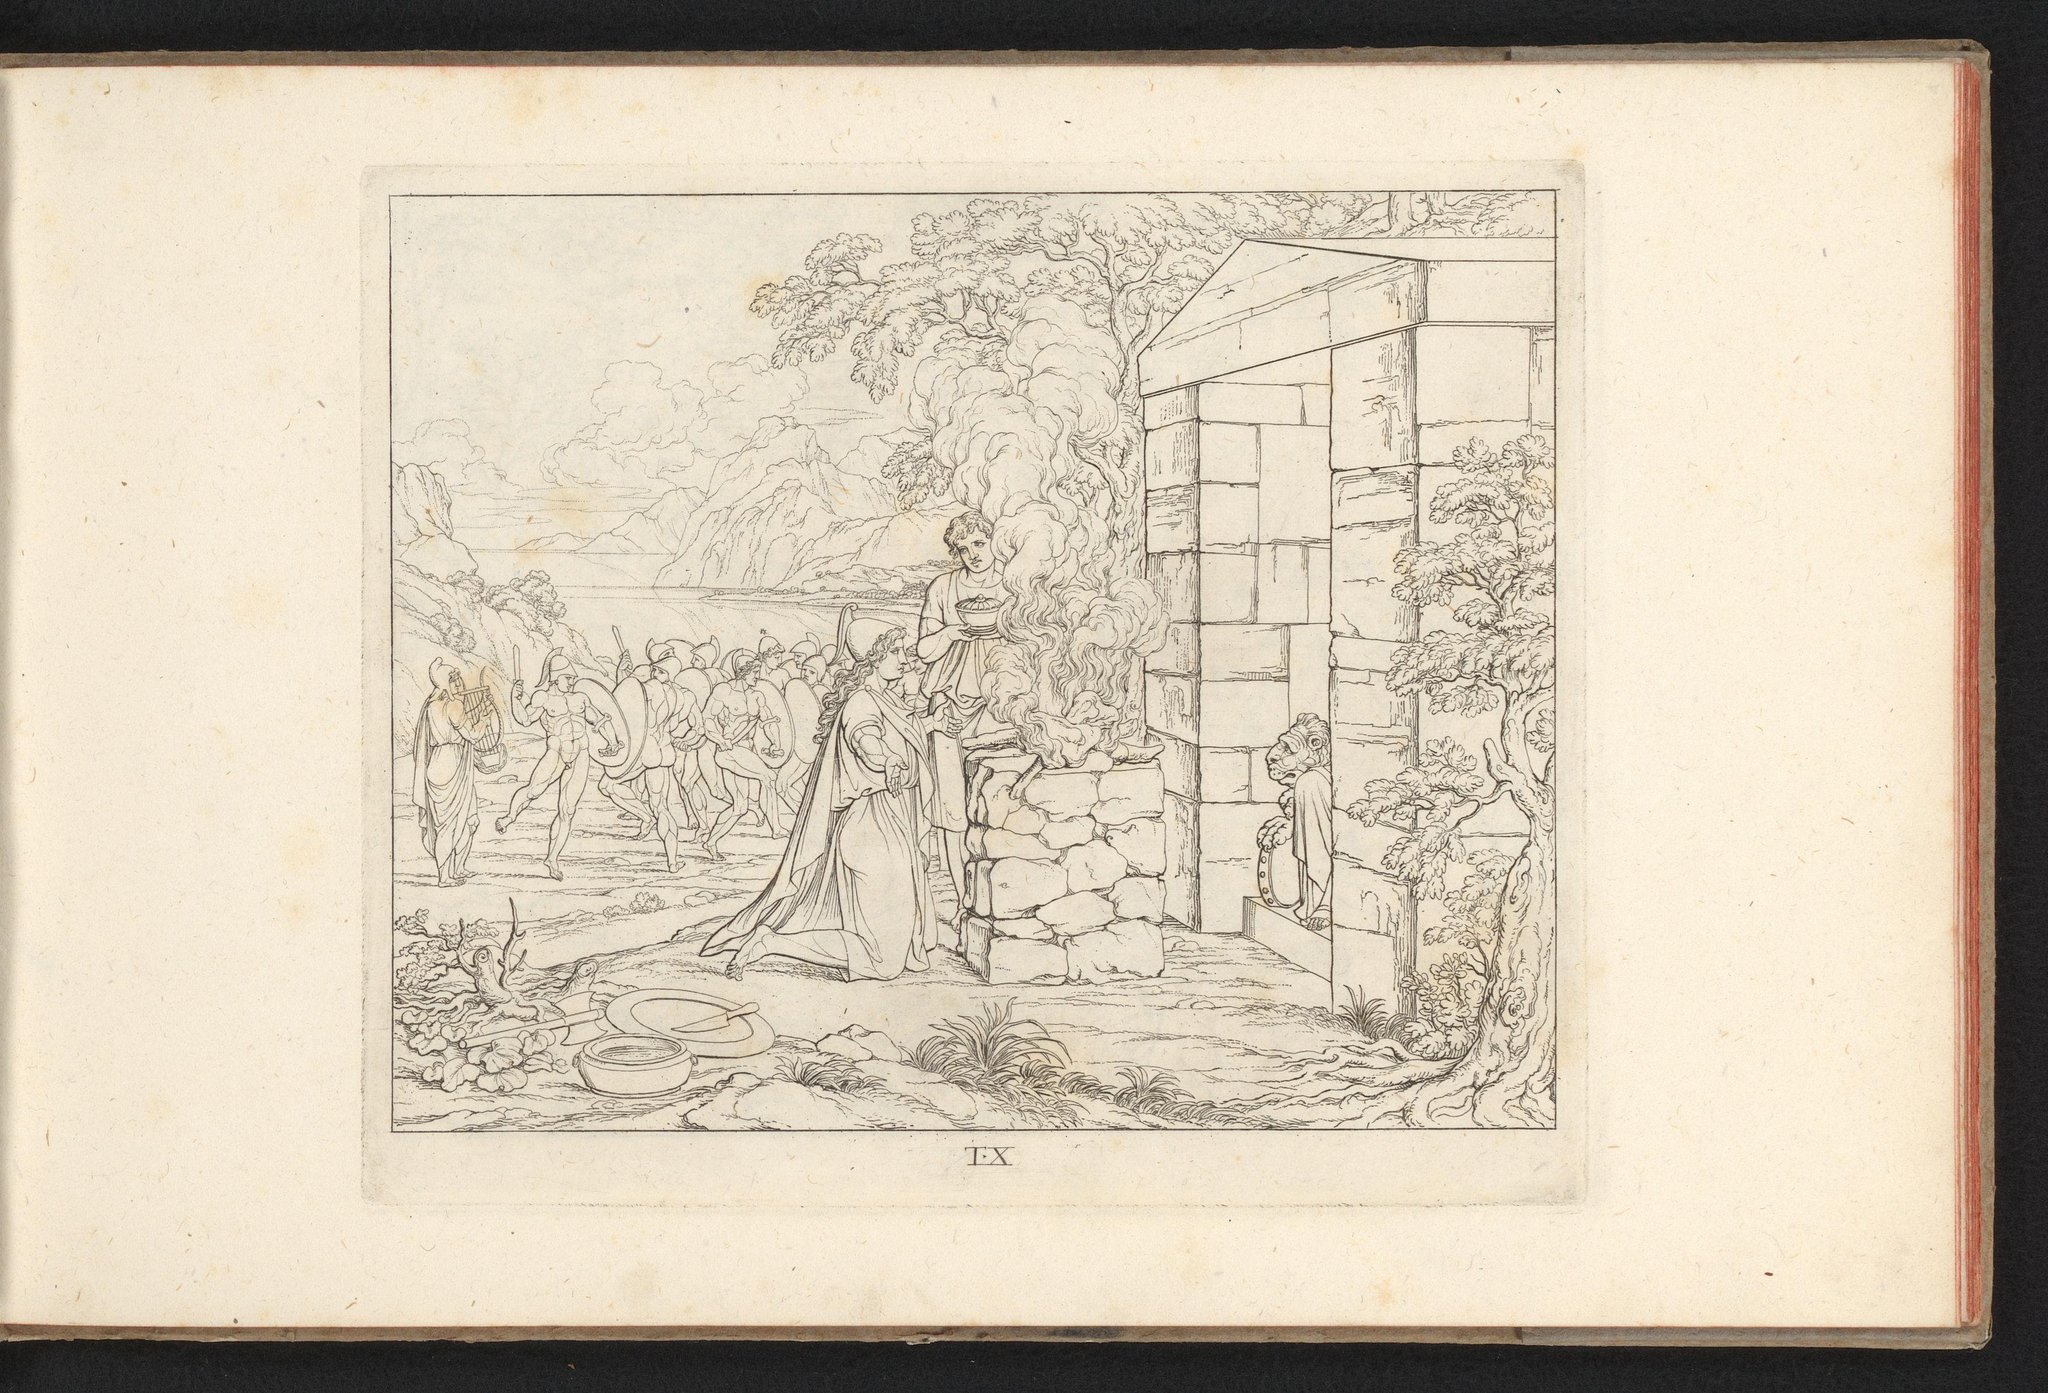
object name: album leaf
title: Jason en de Argonauten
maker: joseph anton koch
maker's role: draughtsman, painter, print maker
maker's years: 1768-1839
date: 1799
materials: paper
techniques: etching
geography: rome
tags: funeral games in honour of cyzicus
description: Deze prent maakt deel uit van een serie met 24 prenten.